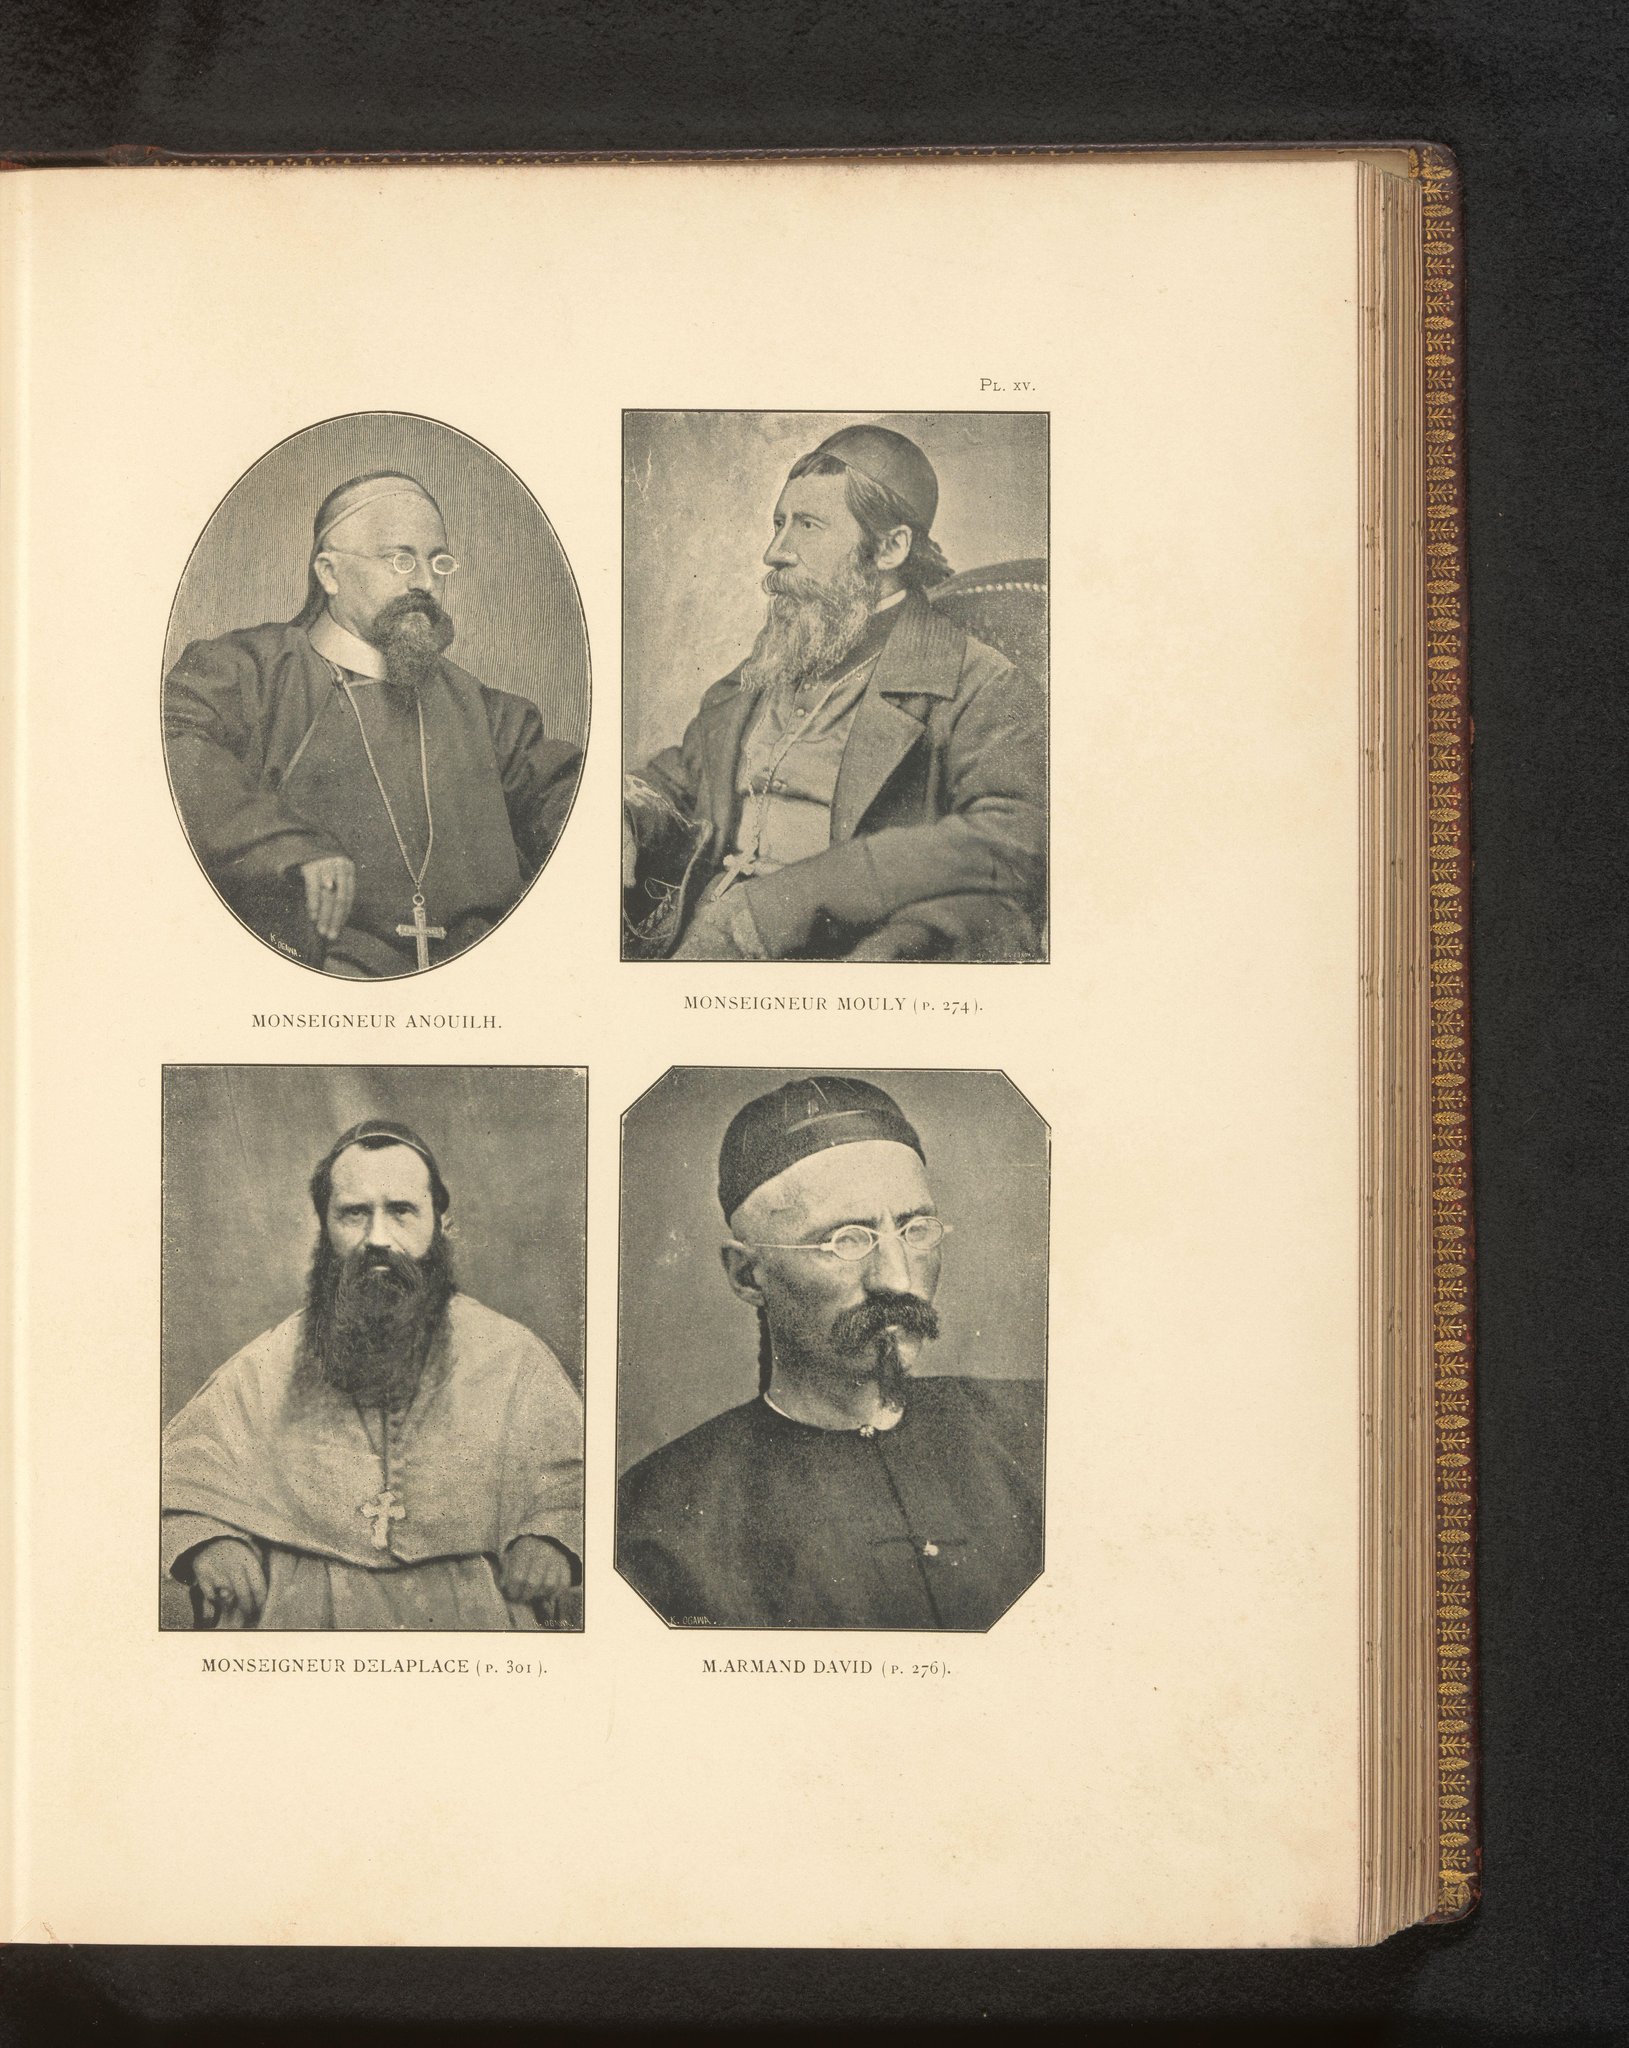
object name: page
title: Portret van Anouilh, Portret van Mouly, Portret van Delaplace en Portret van Armand David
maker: Anonymous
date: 1892-1897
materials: paper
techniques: autotype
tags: france, paris, priest, missionary, adult man, historical persons